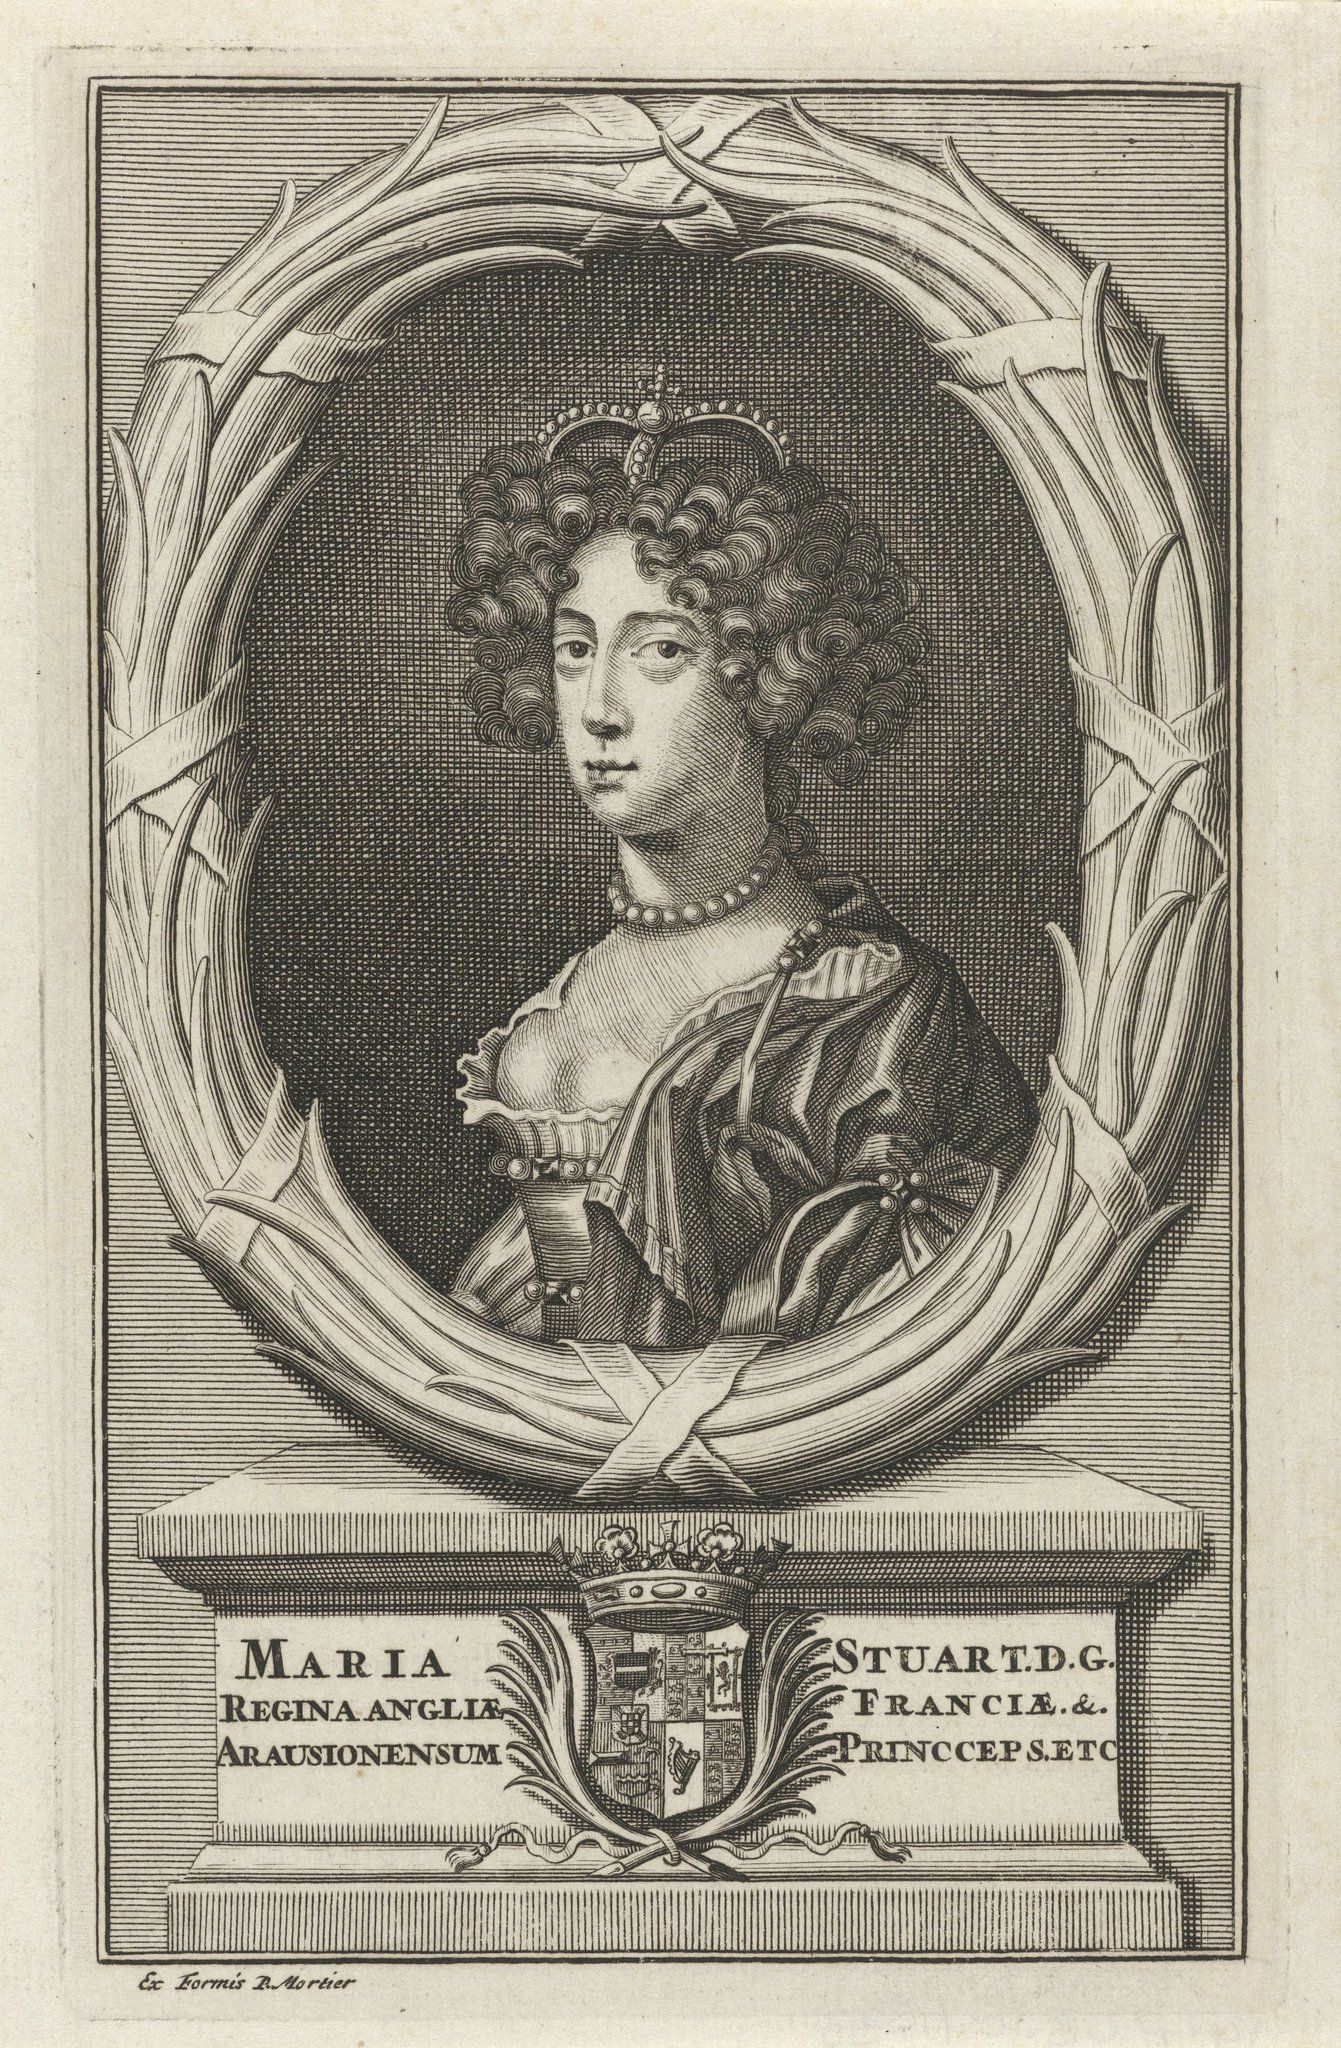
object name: print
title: Portret van Maria II Stuart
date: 1688-1711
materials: paper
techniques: engraving, etching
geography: low countries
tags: london, maria ii stuart (koningin van engeland, schotland en ierland)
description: Portret van Maria II met een kroon in een ovaal van lauwerbladen. Midden onder haar wapen met een kroon. Op een voetstuk haar naam en titels.